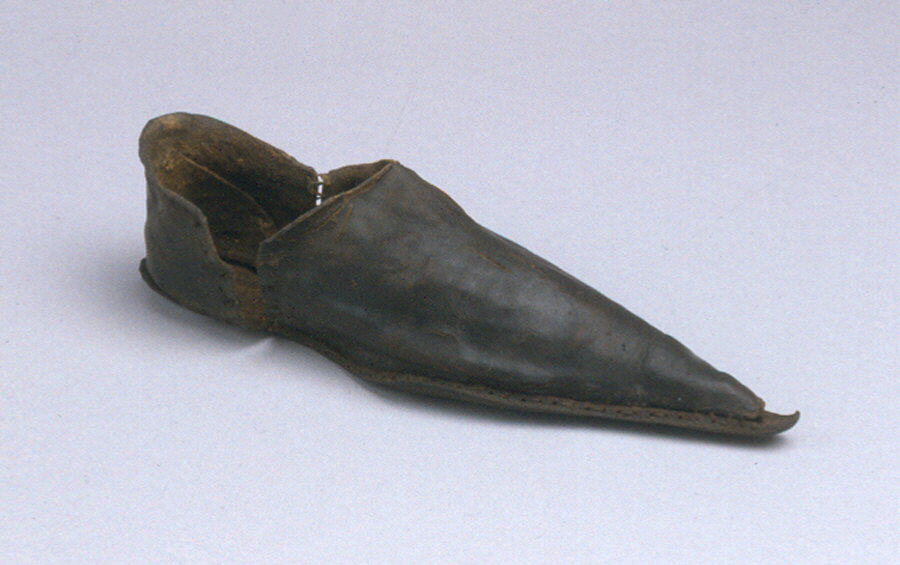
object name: crakow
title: Crakows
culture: british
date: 1300-1450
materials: leather